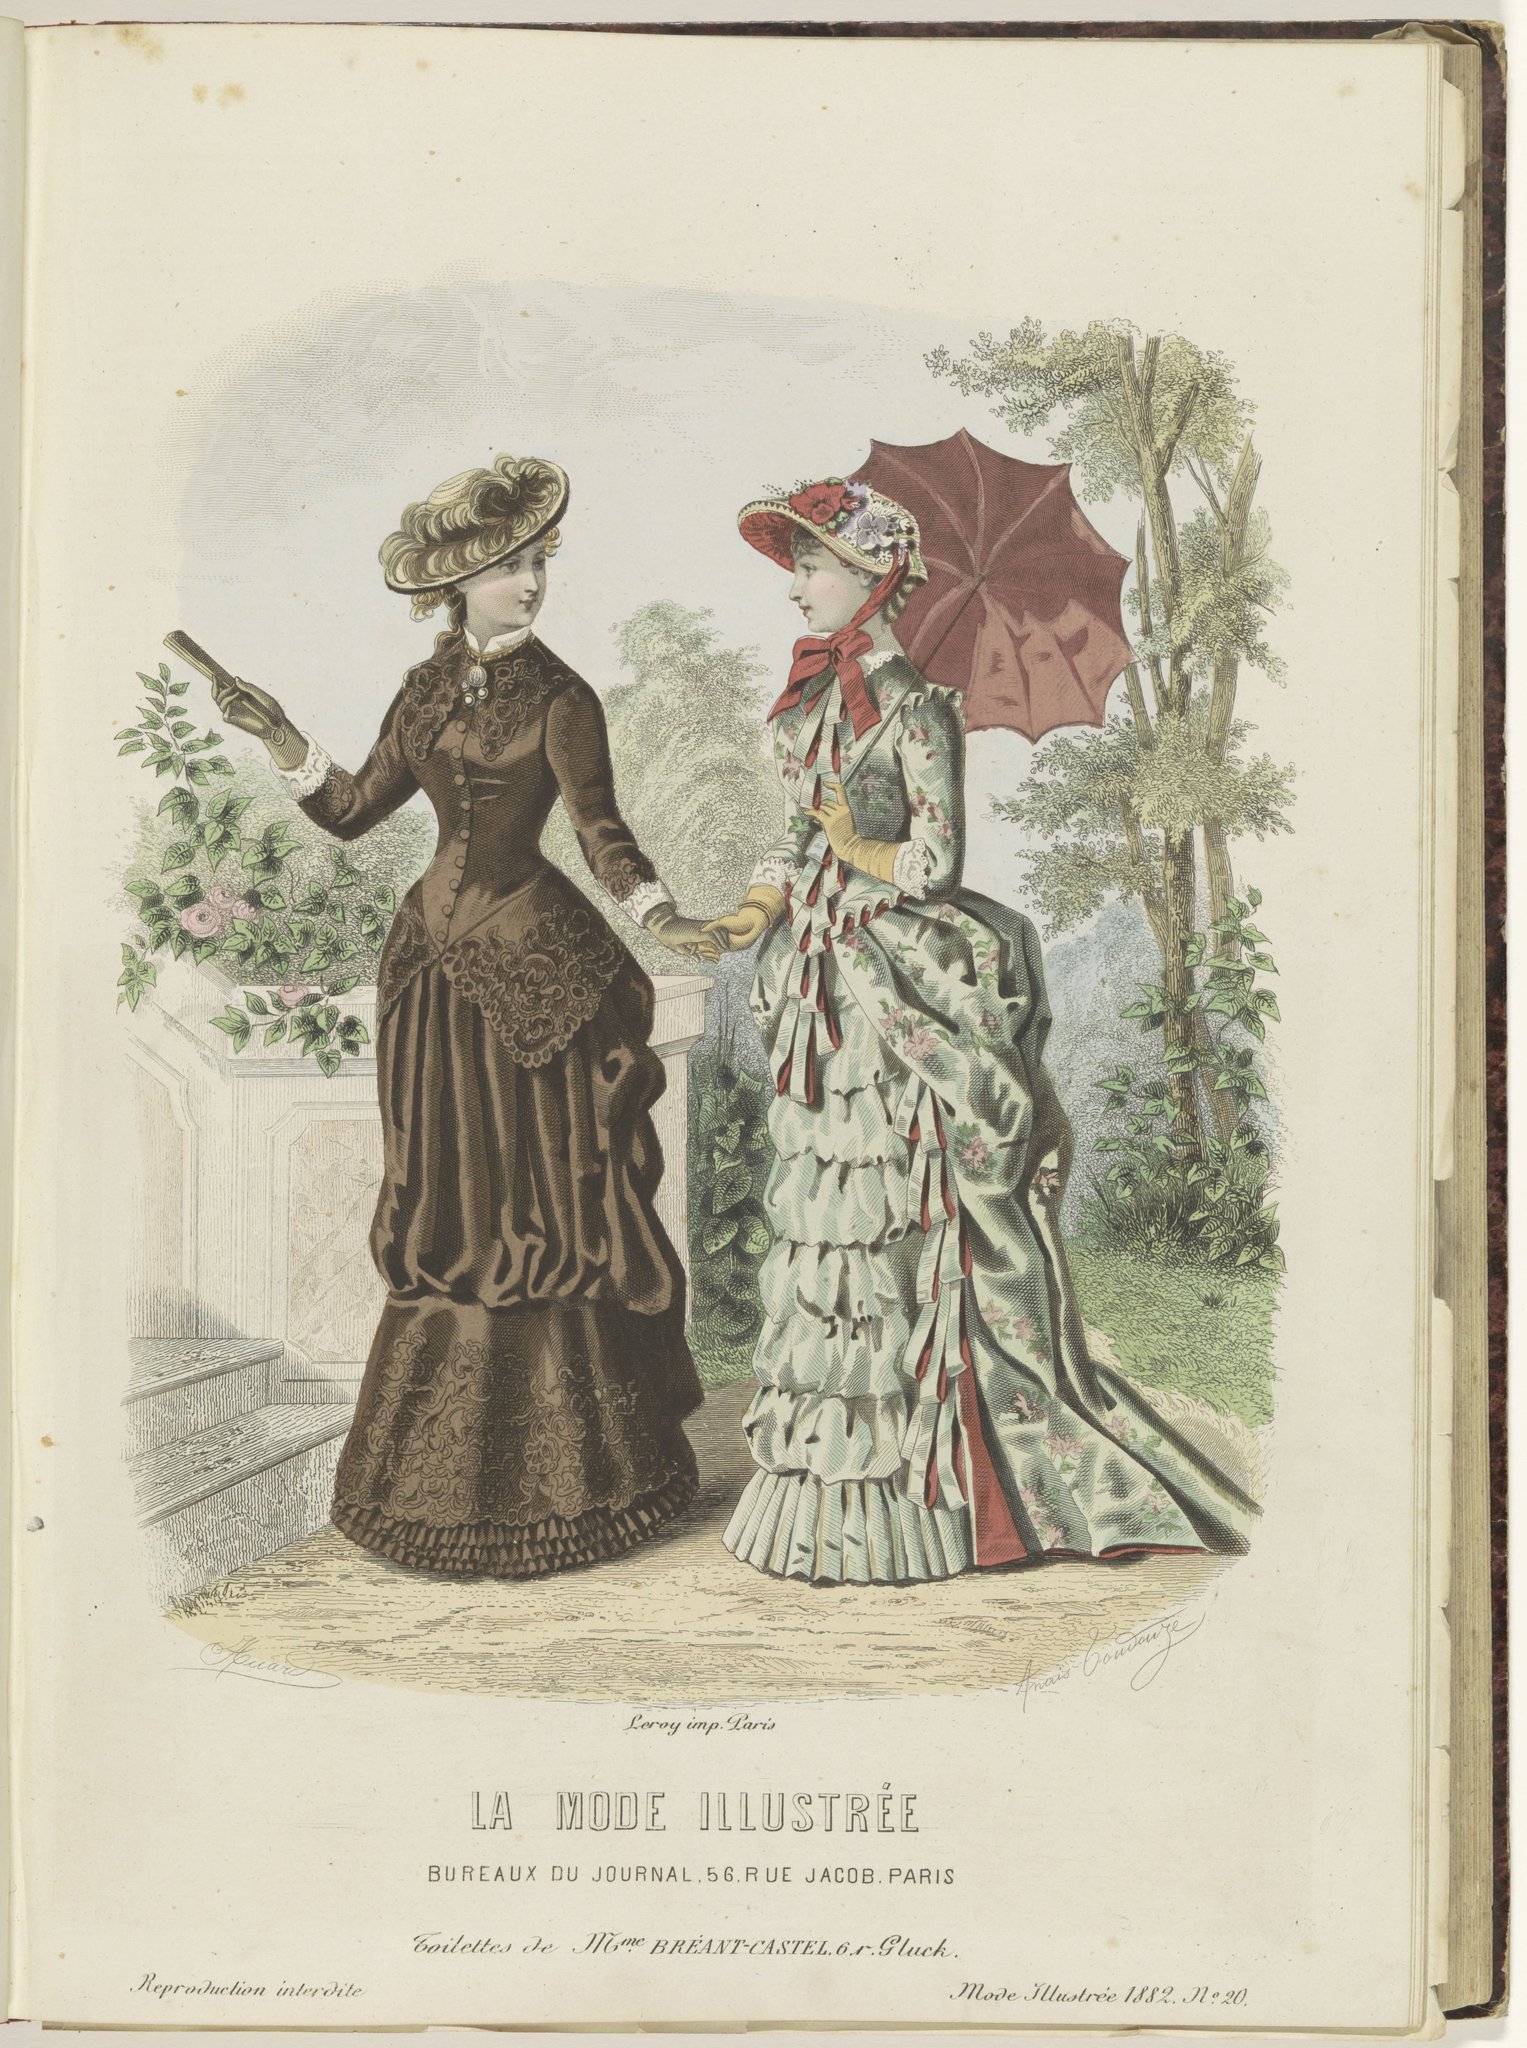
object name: magazine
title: La Mode Illustrée, Journal de la Famille, 1882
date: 1882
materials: paper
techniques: engraving, hand coloring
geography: paris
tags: fashion plates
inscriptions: date